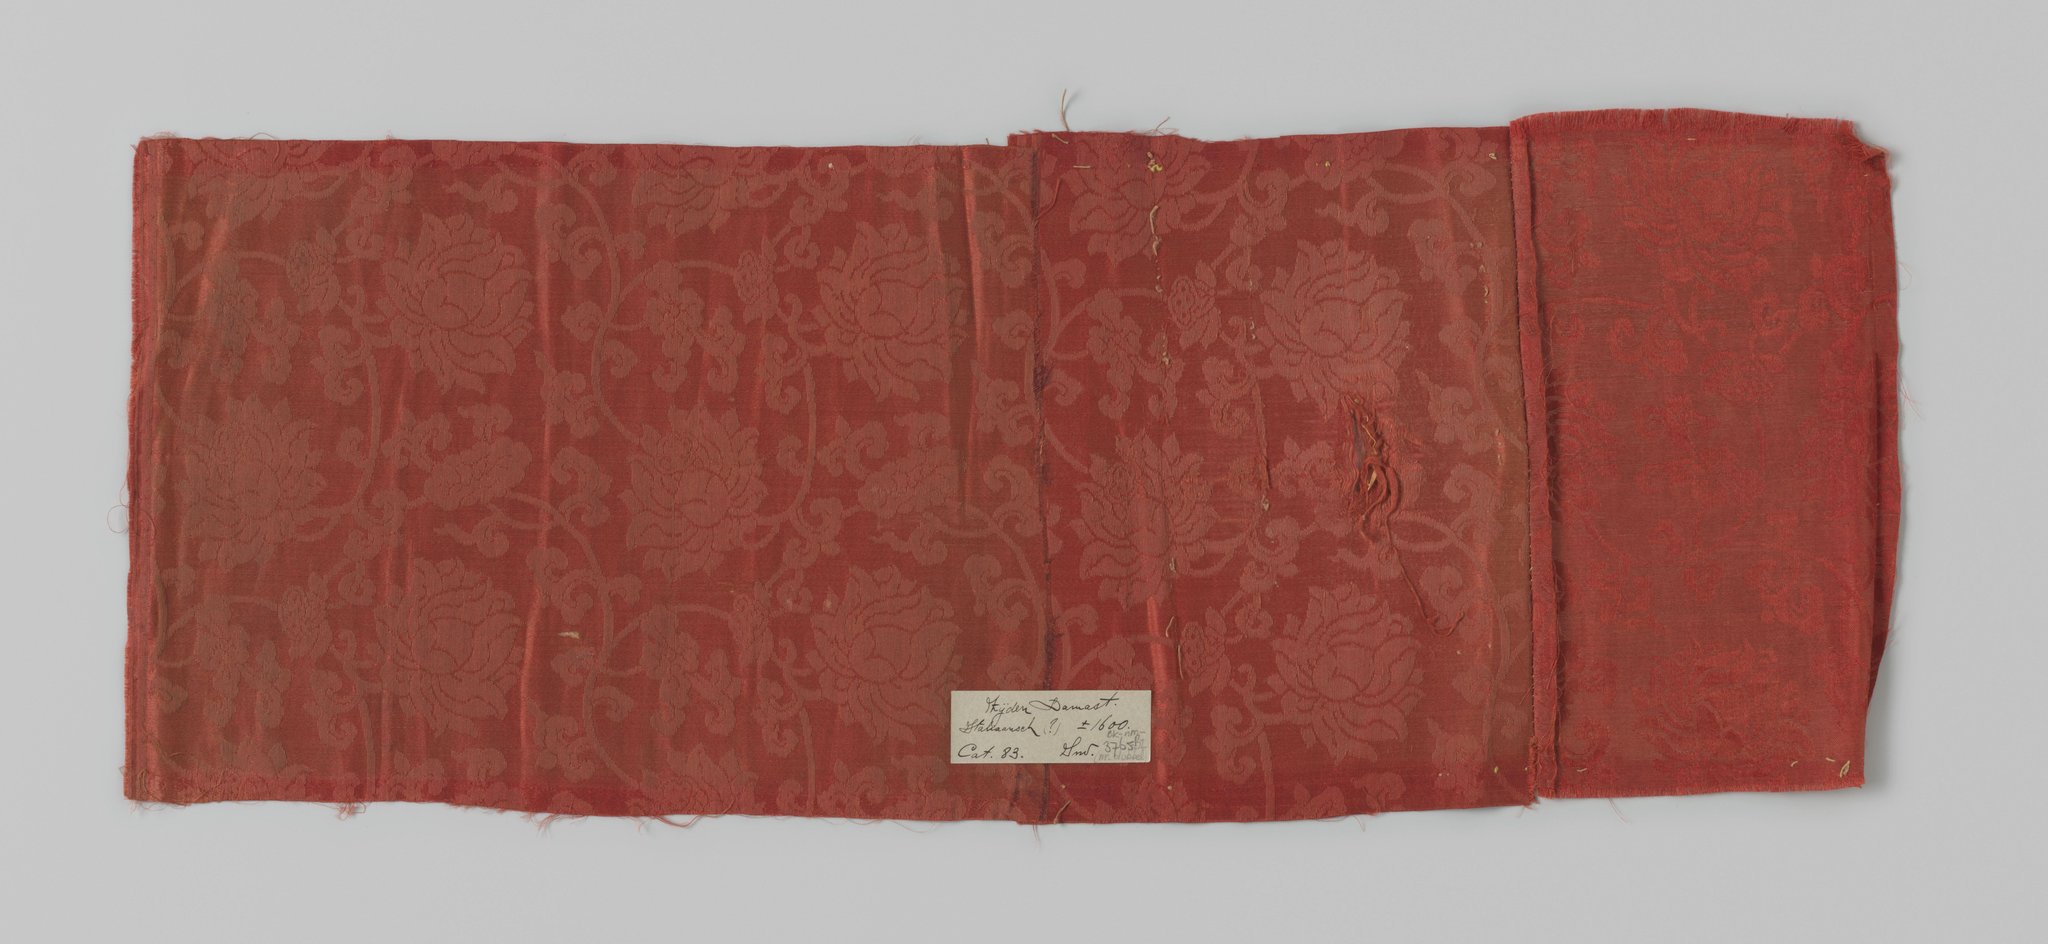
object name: zijdedamast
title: Fragment rood damast met een zelfkant van satijn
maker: Anonymous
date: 1700-1750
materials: silk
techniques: damask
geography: china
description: Fragment rode damast, oosters textiel. Het patroon heeft bloemen met omgekrulde takken.